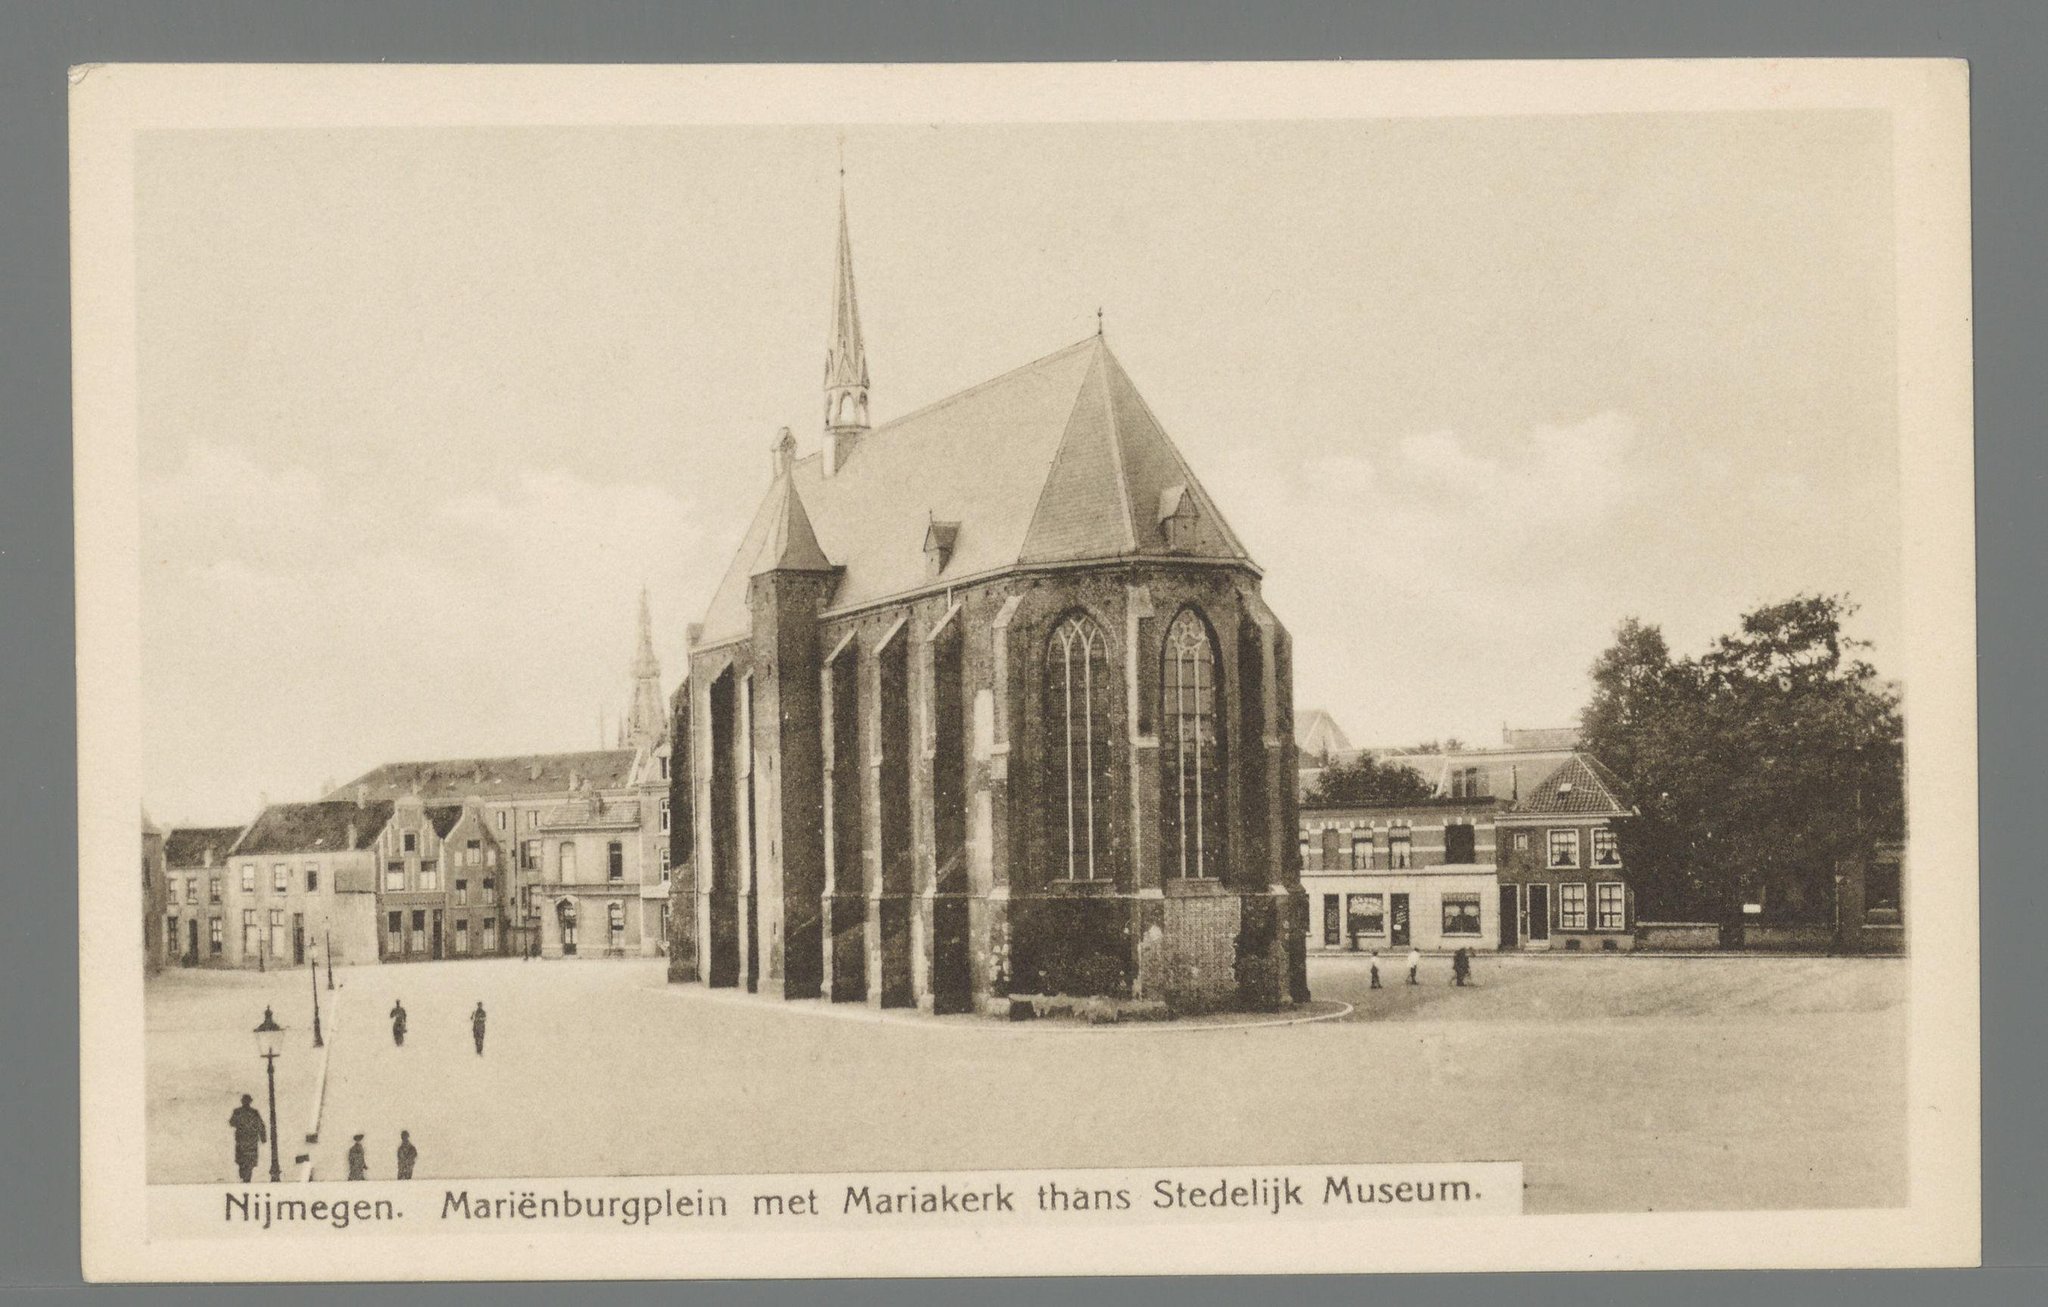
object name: photomechanical print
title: Nijmegen. Mariënburgplein met Mariakerk thans Stedelijk Museum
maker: Anonymous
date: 1914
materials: cardboard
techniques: photograph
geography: leipzig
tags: square, place, circus, etc., church (exterior), permanent exhibition, museum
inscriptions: date